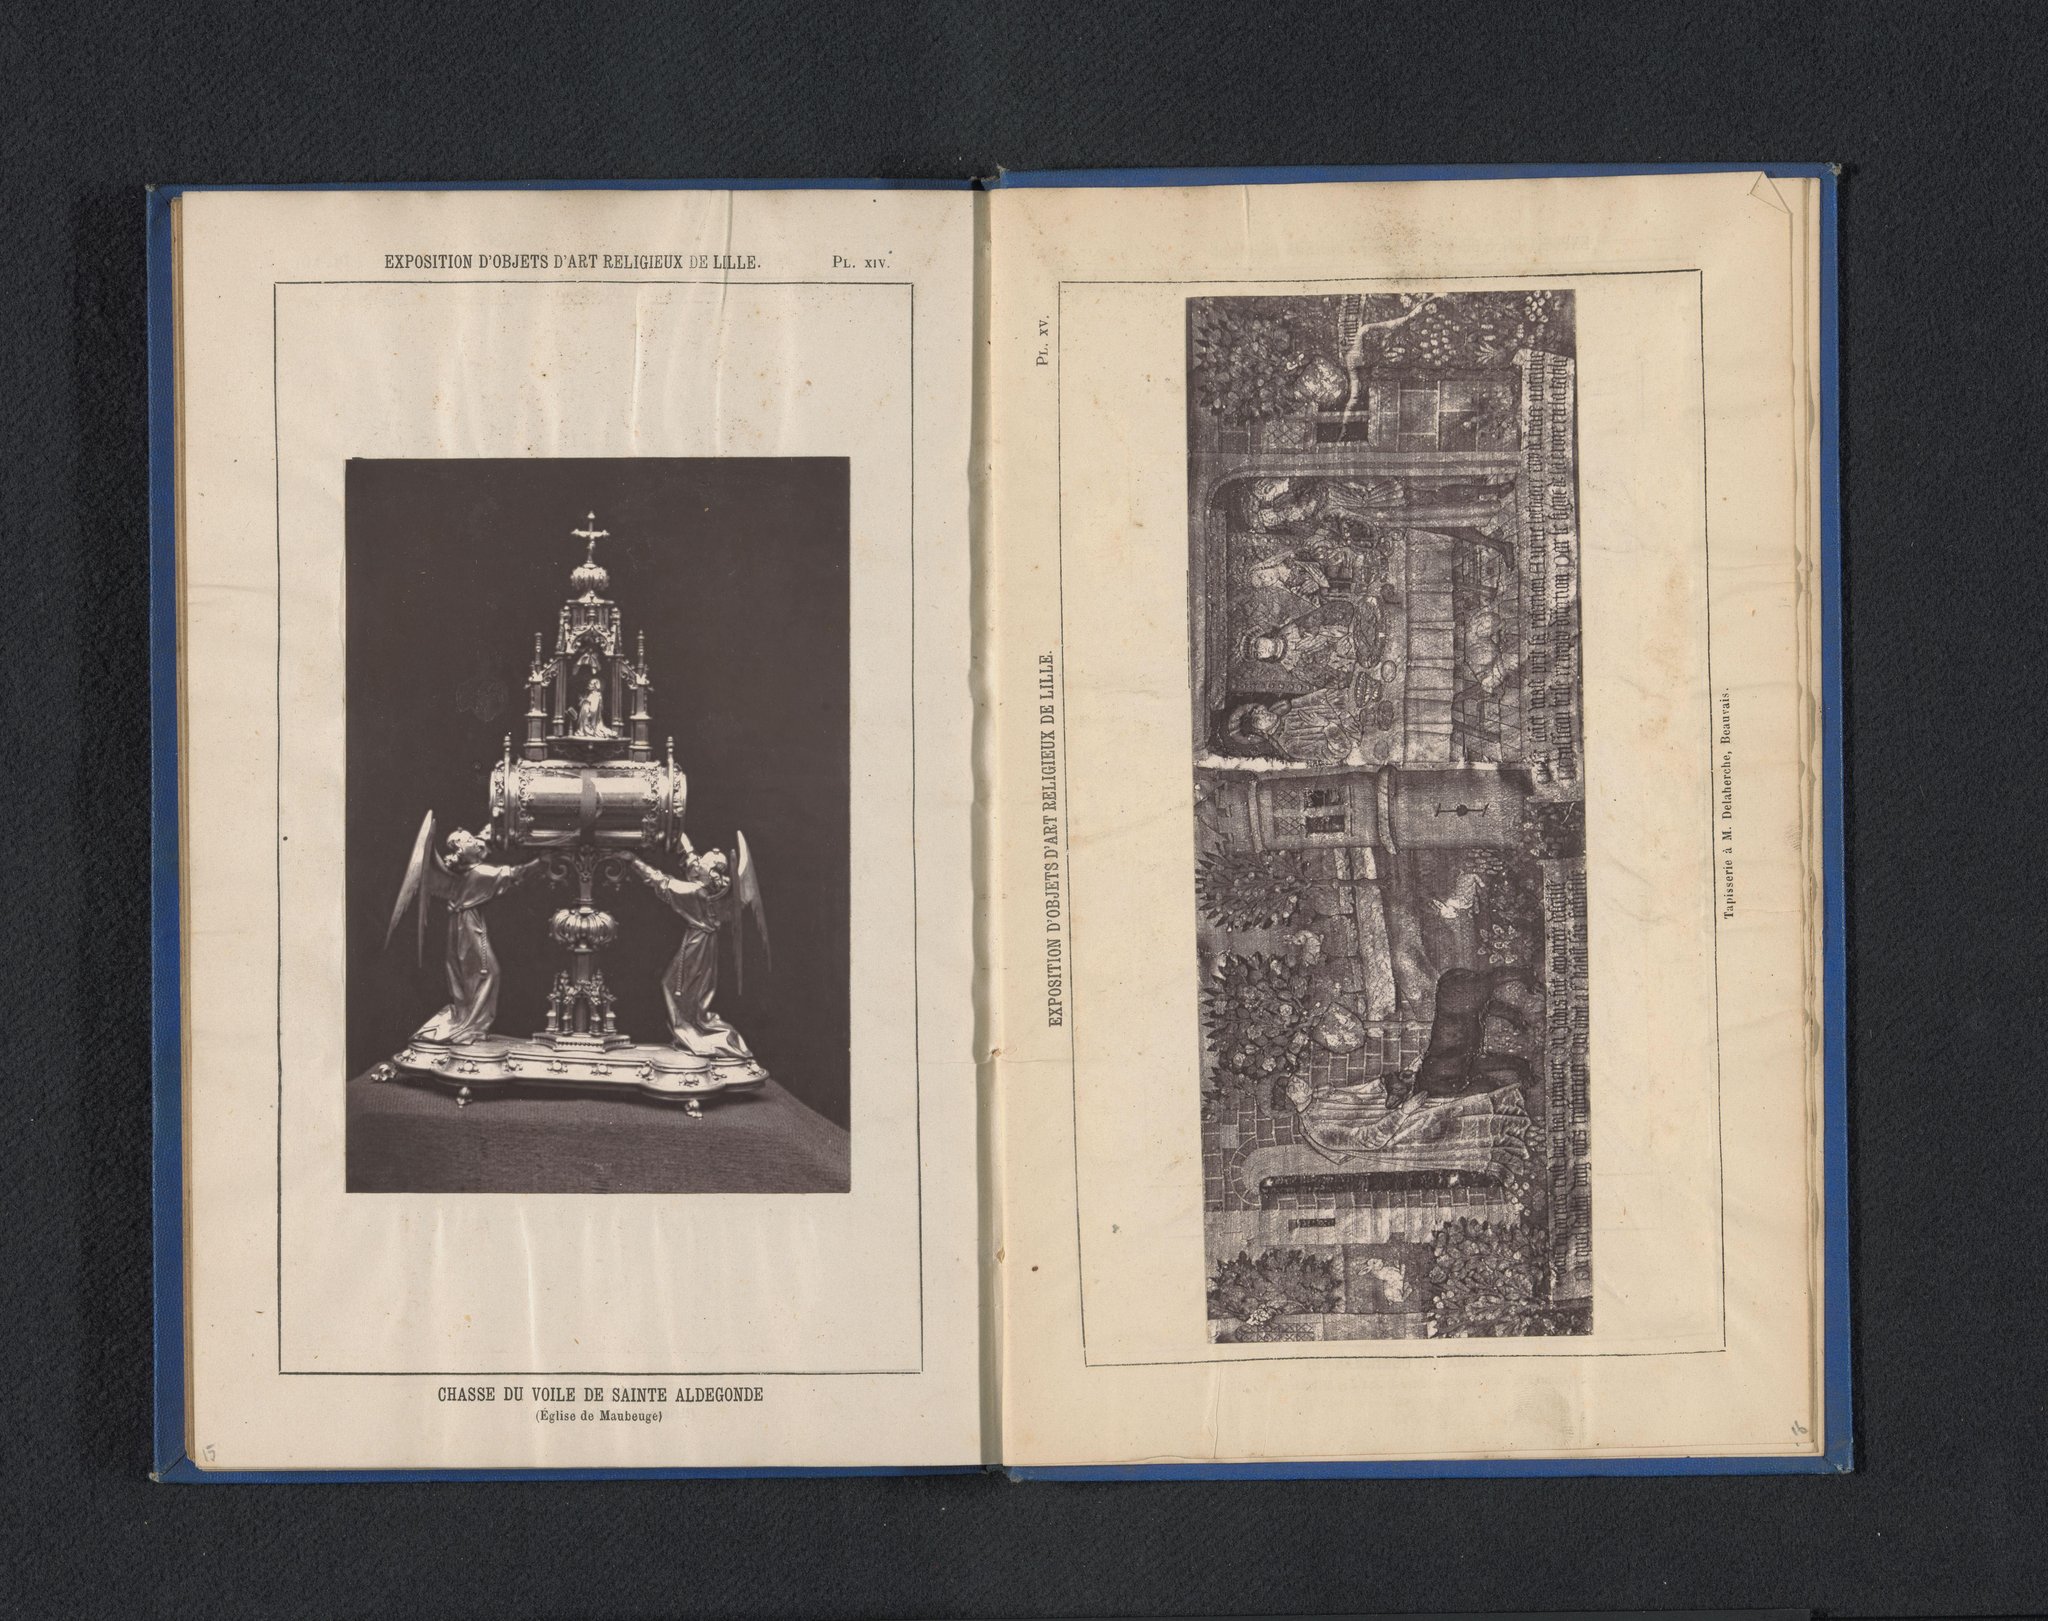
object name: photomechanical print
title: Wandtapijt met religieuze voorstelling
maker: Anonymous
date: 1871-1876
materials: cardboard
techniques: woodburytype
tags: tapestry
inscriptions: inscription: ‘Exposition d'objets d'art religieux de Lille’, inscription: ‘Pl. XV.’, inscription: ‘Tapisserie à M. Delaherche, Beauvais’